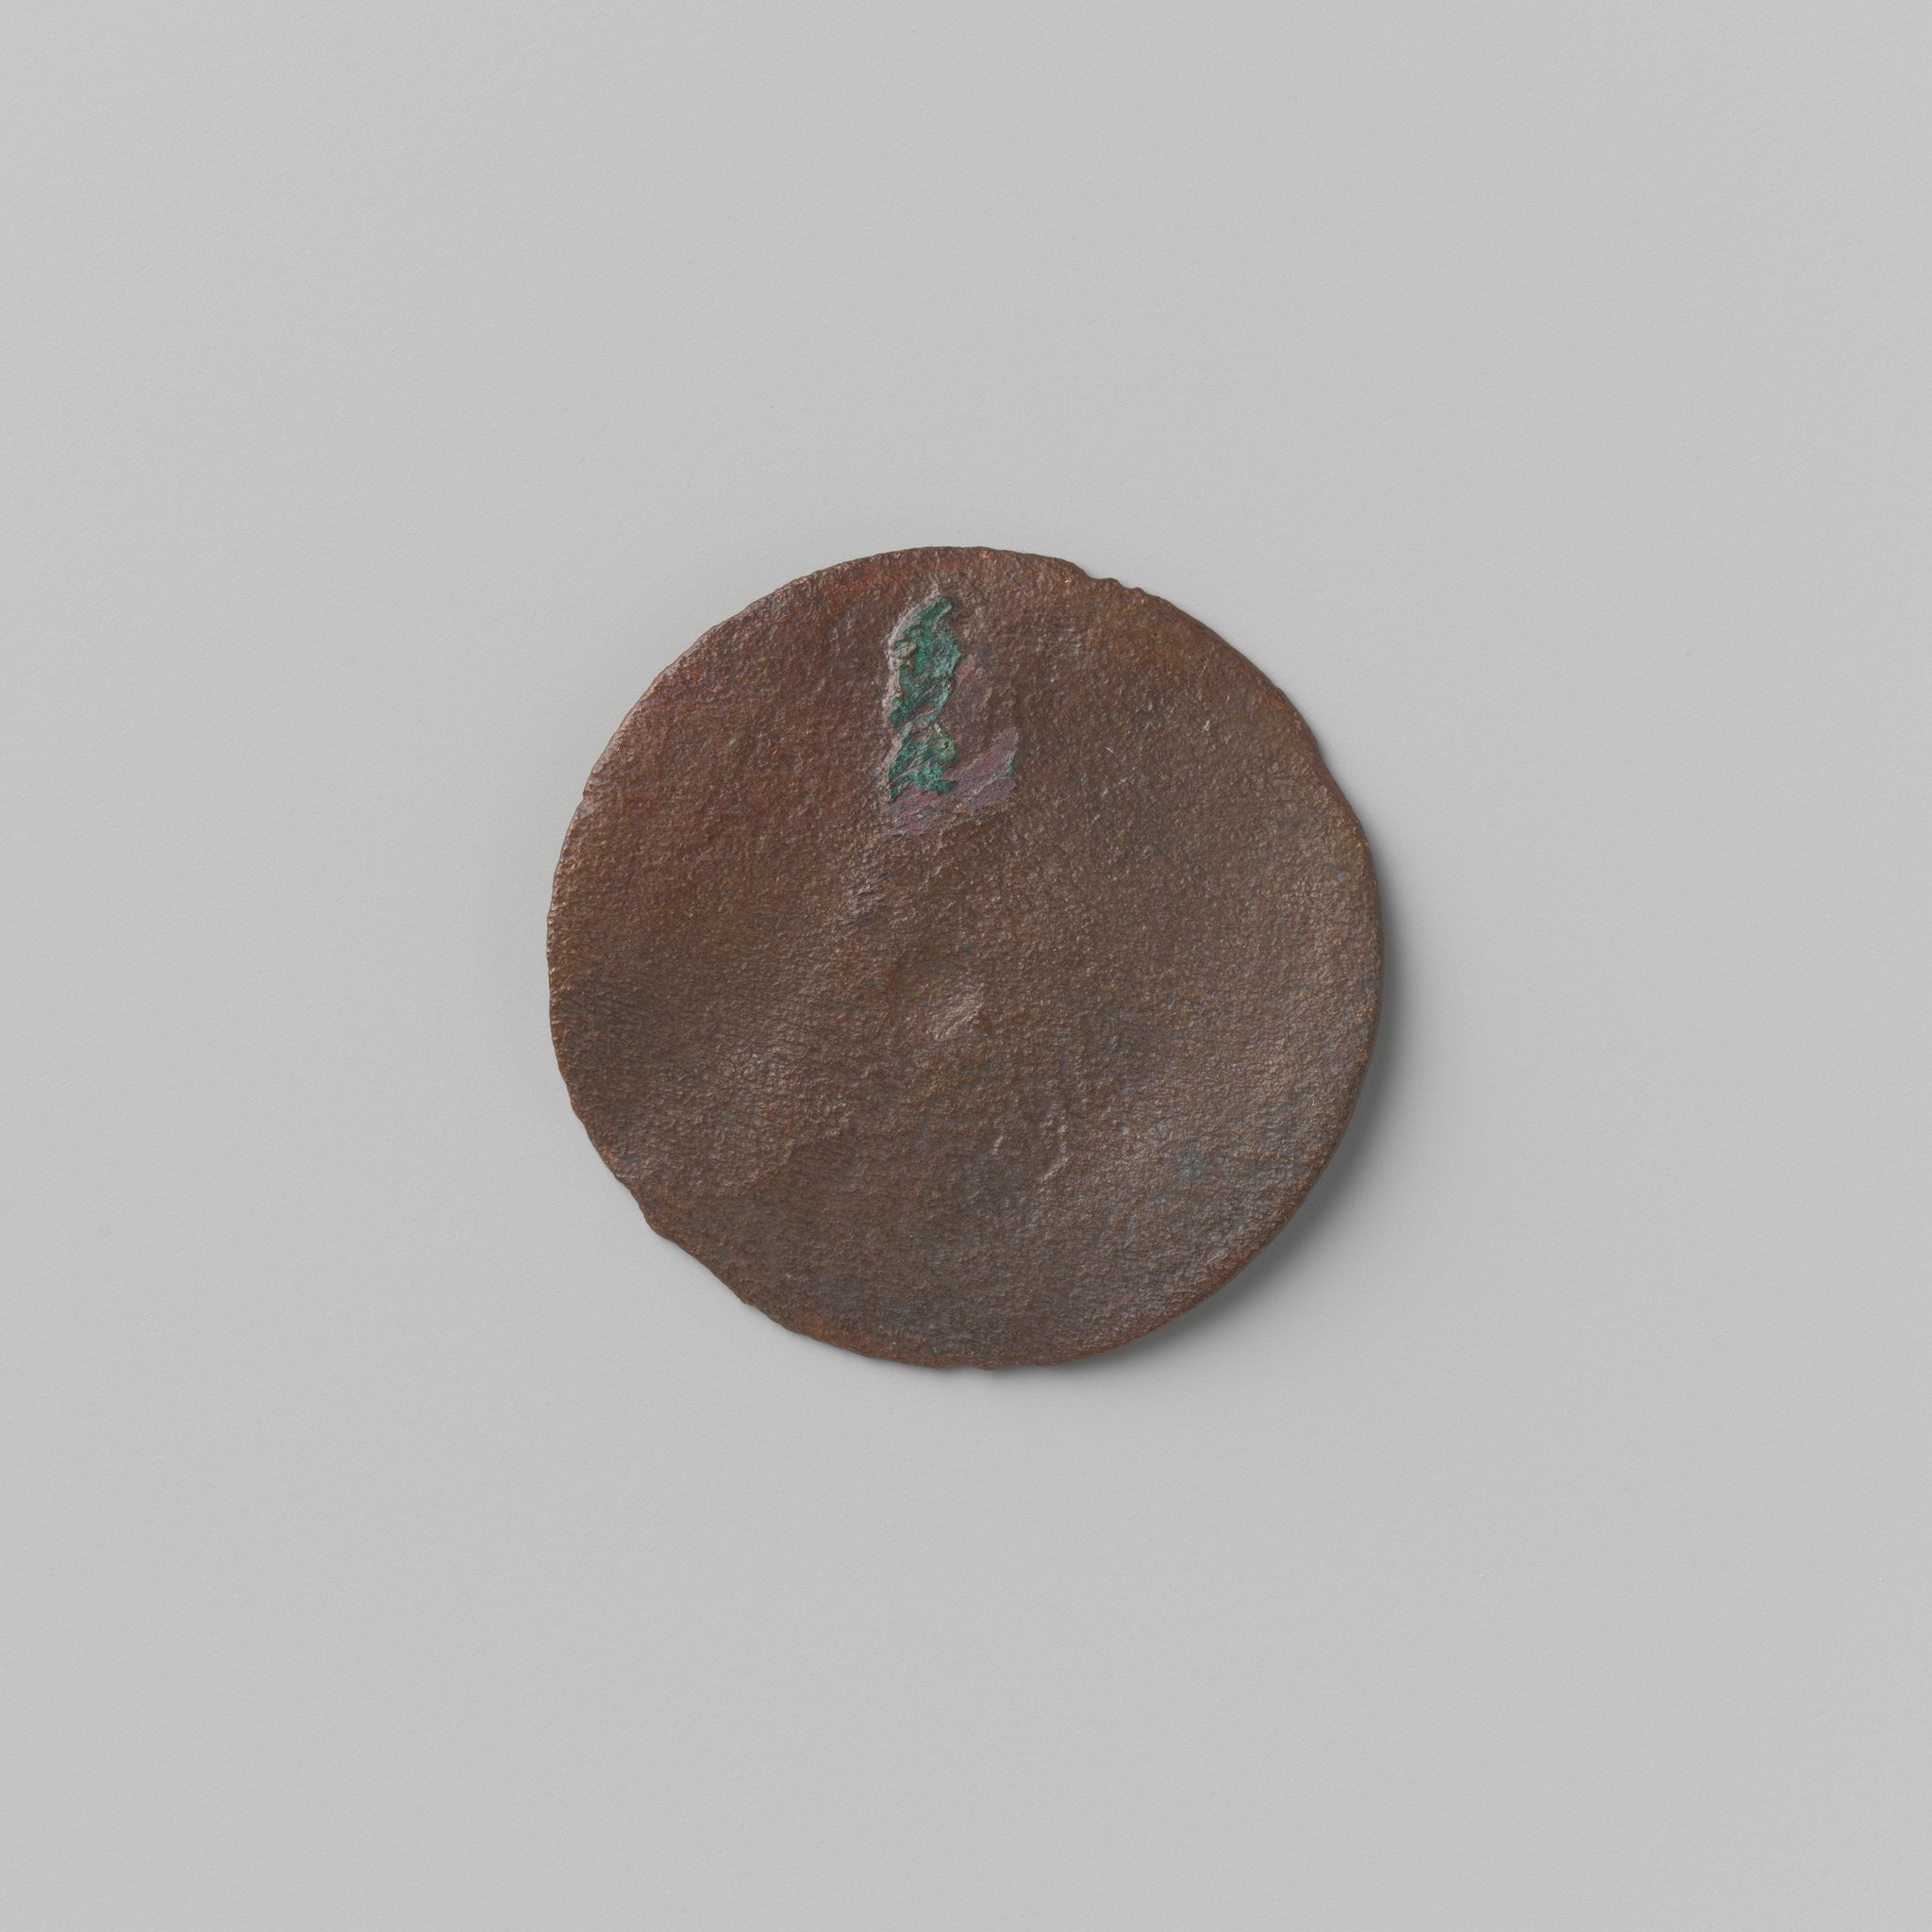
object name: tien real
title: Rondel (ongeslagen muntplaatje)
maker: Anonymous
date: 1700-1800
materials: copper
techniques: striking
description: Rondel, gevonden op het strand van Terschelling, waarschijnlijk van Zweedse oorsprong en in Göteborg of Hamburg ingeladen in een schip dat – op weg naar Lissabon – nabij Terschelling zonk.